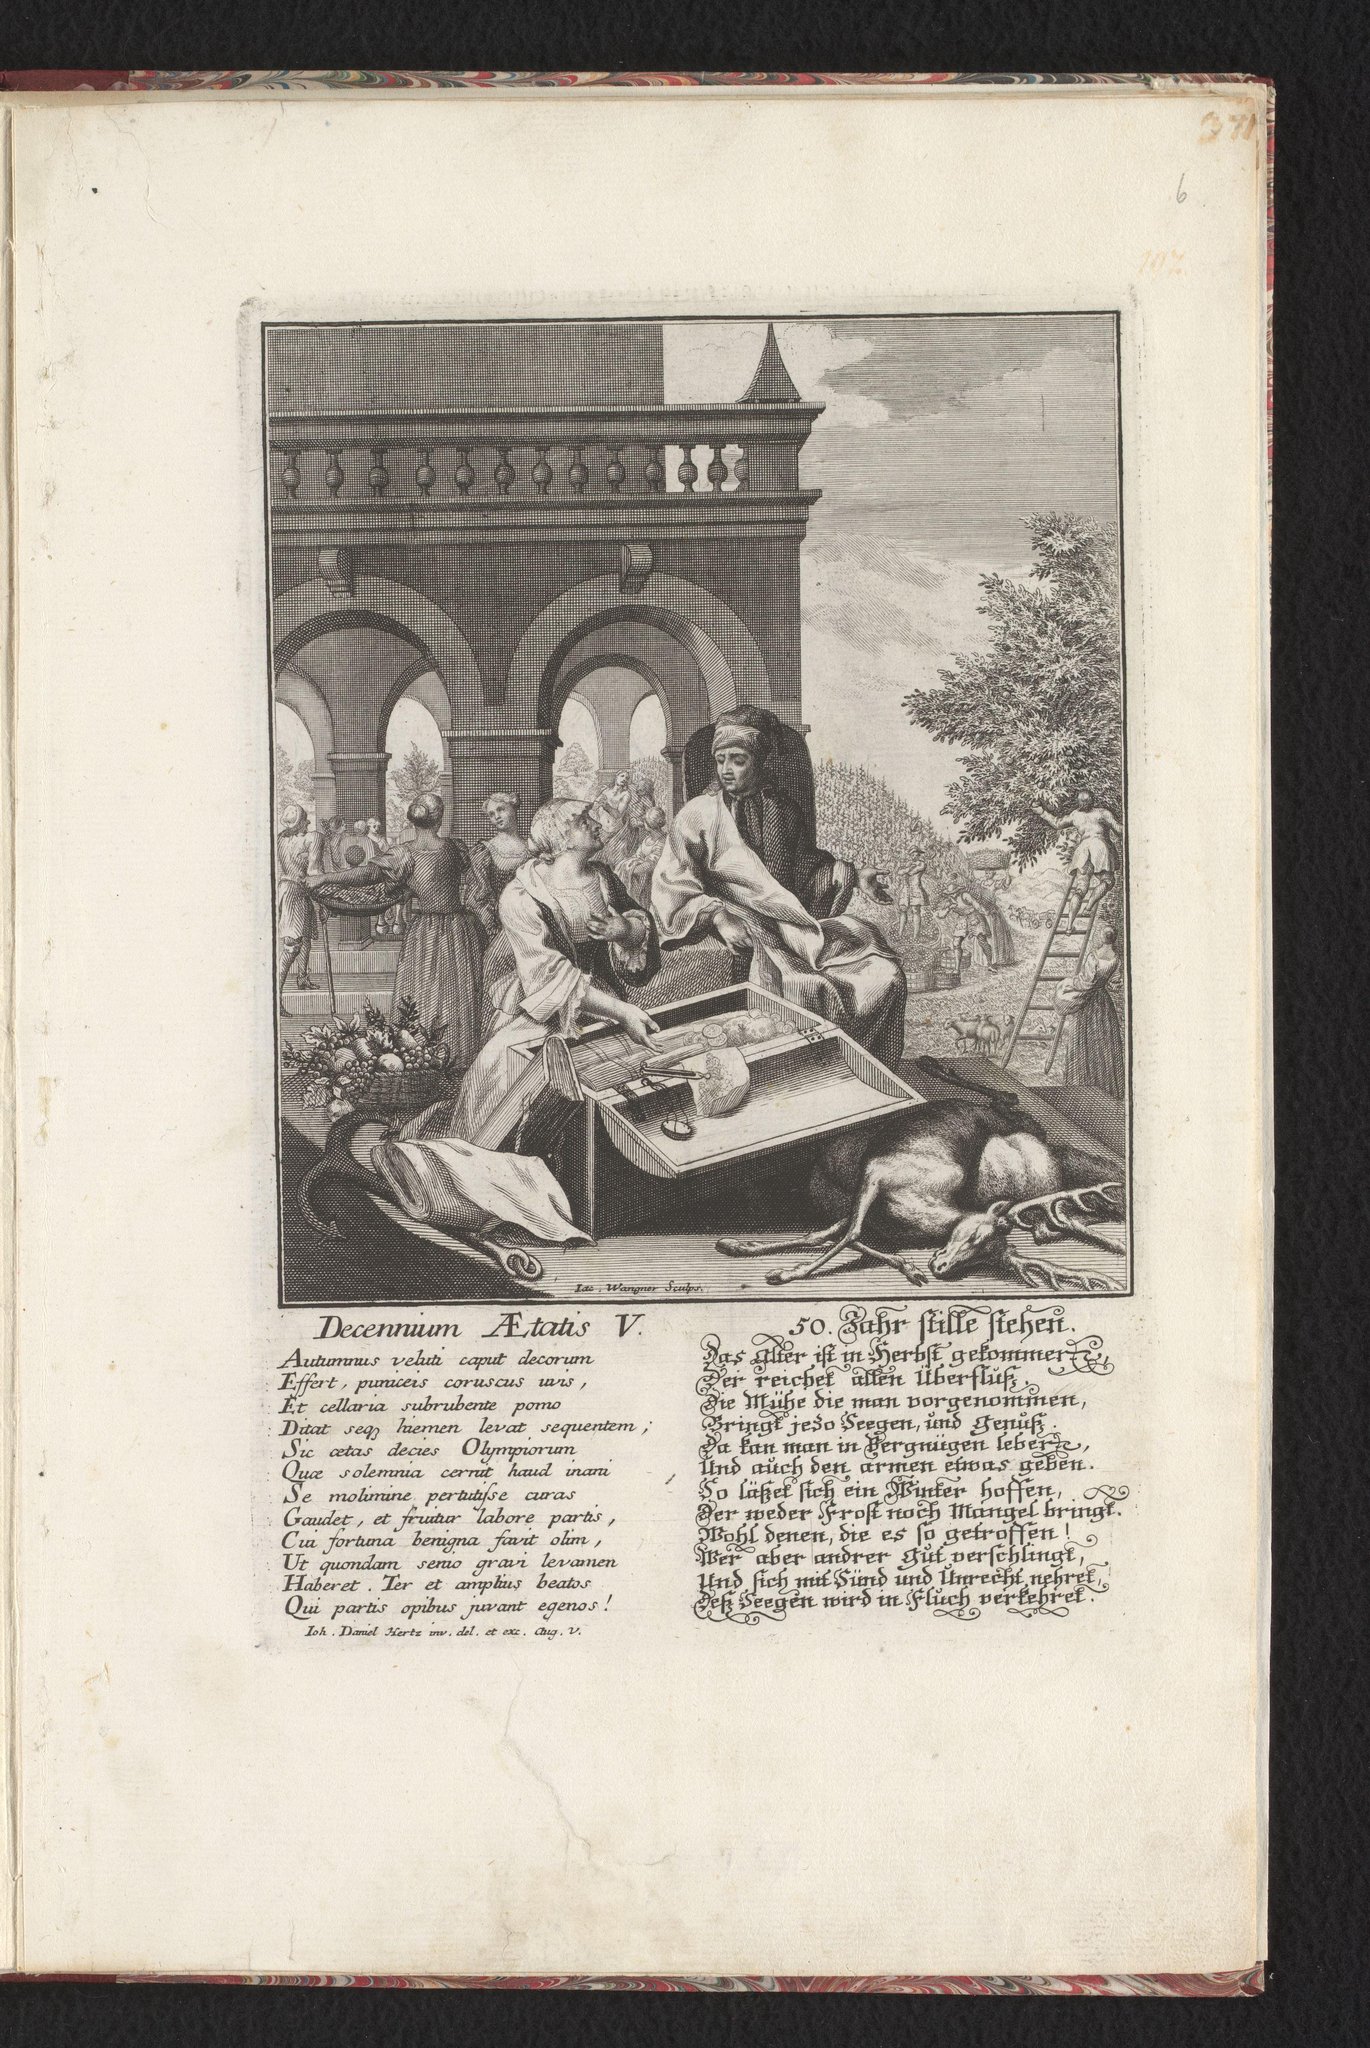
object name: album leaf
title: De mens op vijftigjarige leeftijd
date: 1725-1730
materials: paper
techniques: engraving, etching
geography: augsburg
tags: 40-50 years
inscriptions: number, watermark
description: Een man en vrouw zitten voor een geldkist. Op de grond een dood hert en een anker. Op de achtergrond fruitoogst. Met gedichten in Latijn en Duits. Deze prent maakt deel uit van een album.